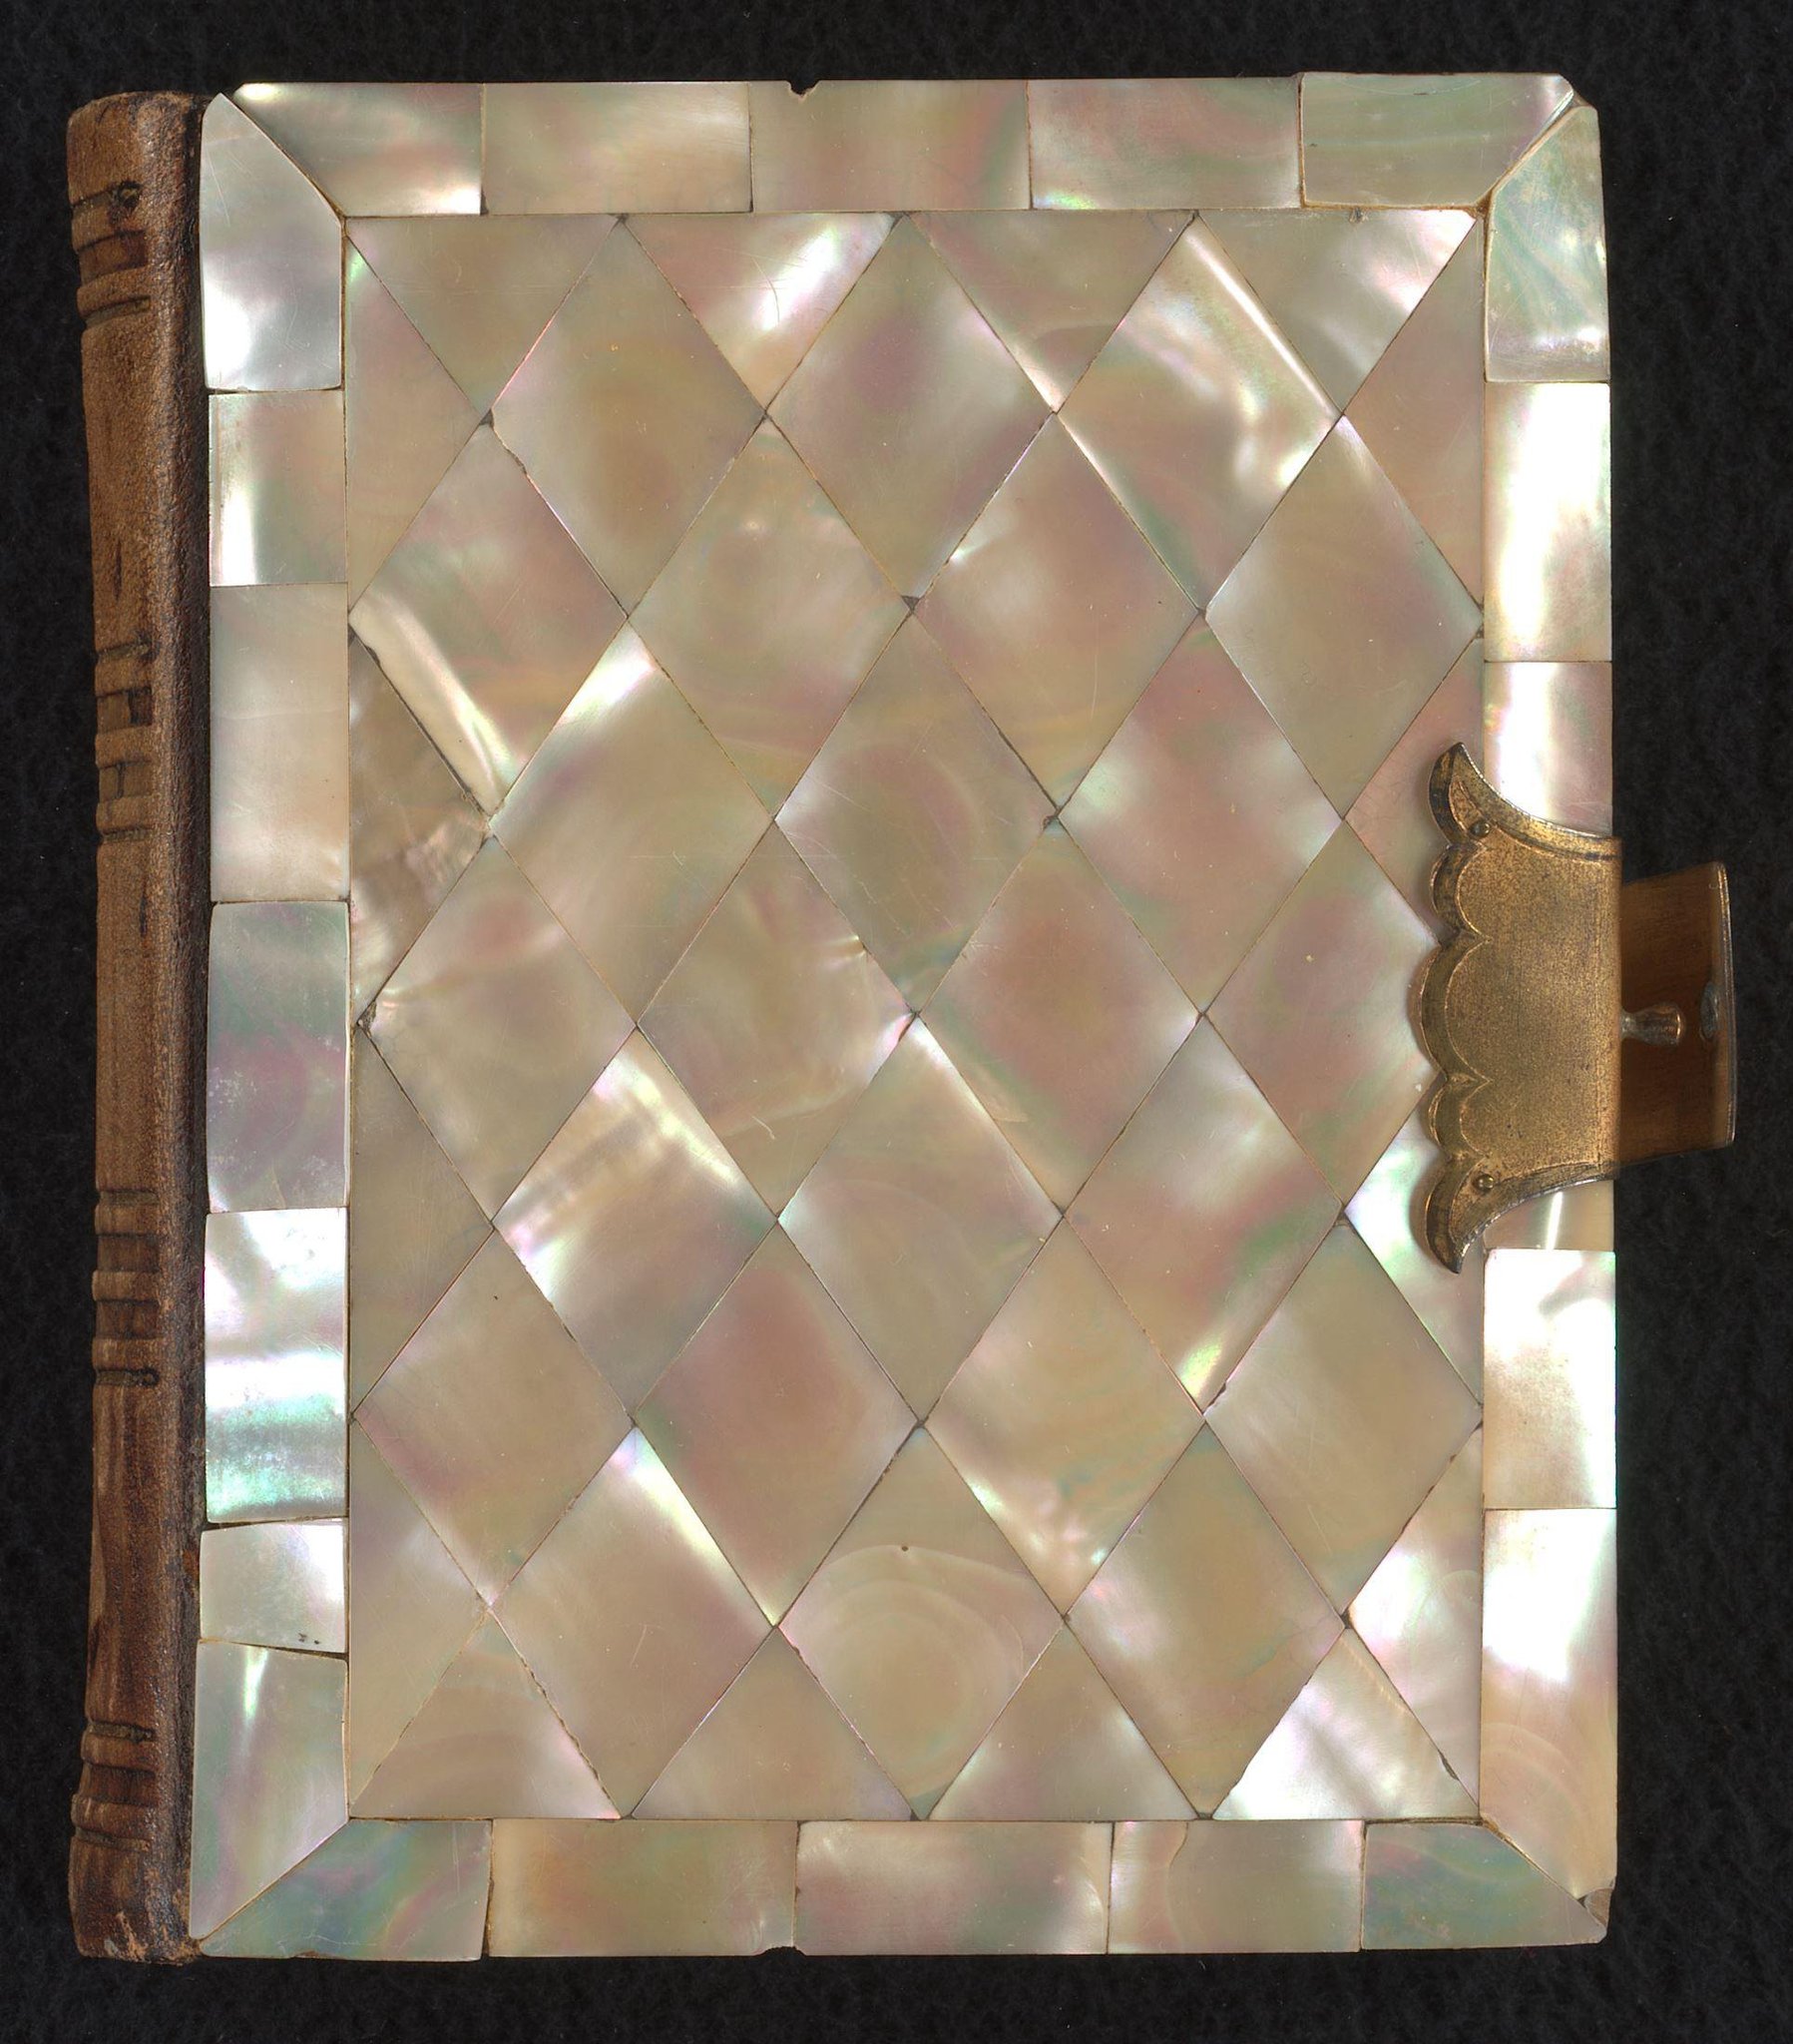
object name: slip in album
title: Familiealbum met 45 foto's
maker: Anonymous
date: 1860-1900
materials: cardboard, iron, metal, mother of pearl, photographic support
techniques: albumen print, ferrotyping, gelatin silver print, hand coloring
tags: adult woman, boy (child between toddler and youth), adult man, historical persons, girl (child between toddler and youth)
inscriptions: inscription: ‘Dienst Verspreide Rijkskollekties (...)’, annotation: ‘[...] e/t’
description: Familiealbum met in totaal 45 foto's; alle cartes-de-visite. Het album bevat portretten van mannen, vrouwen en kinderen.